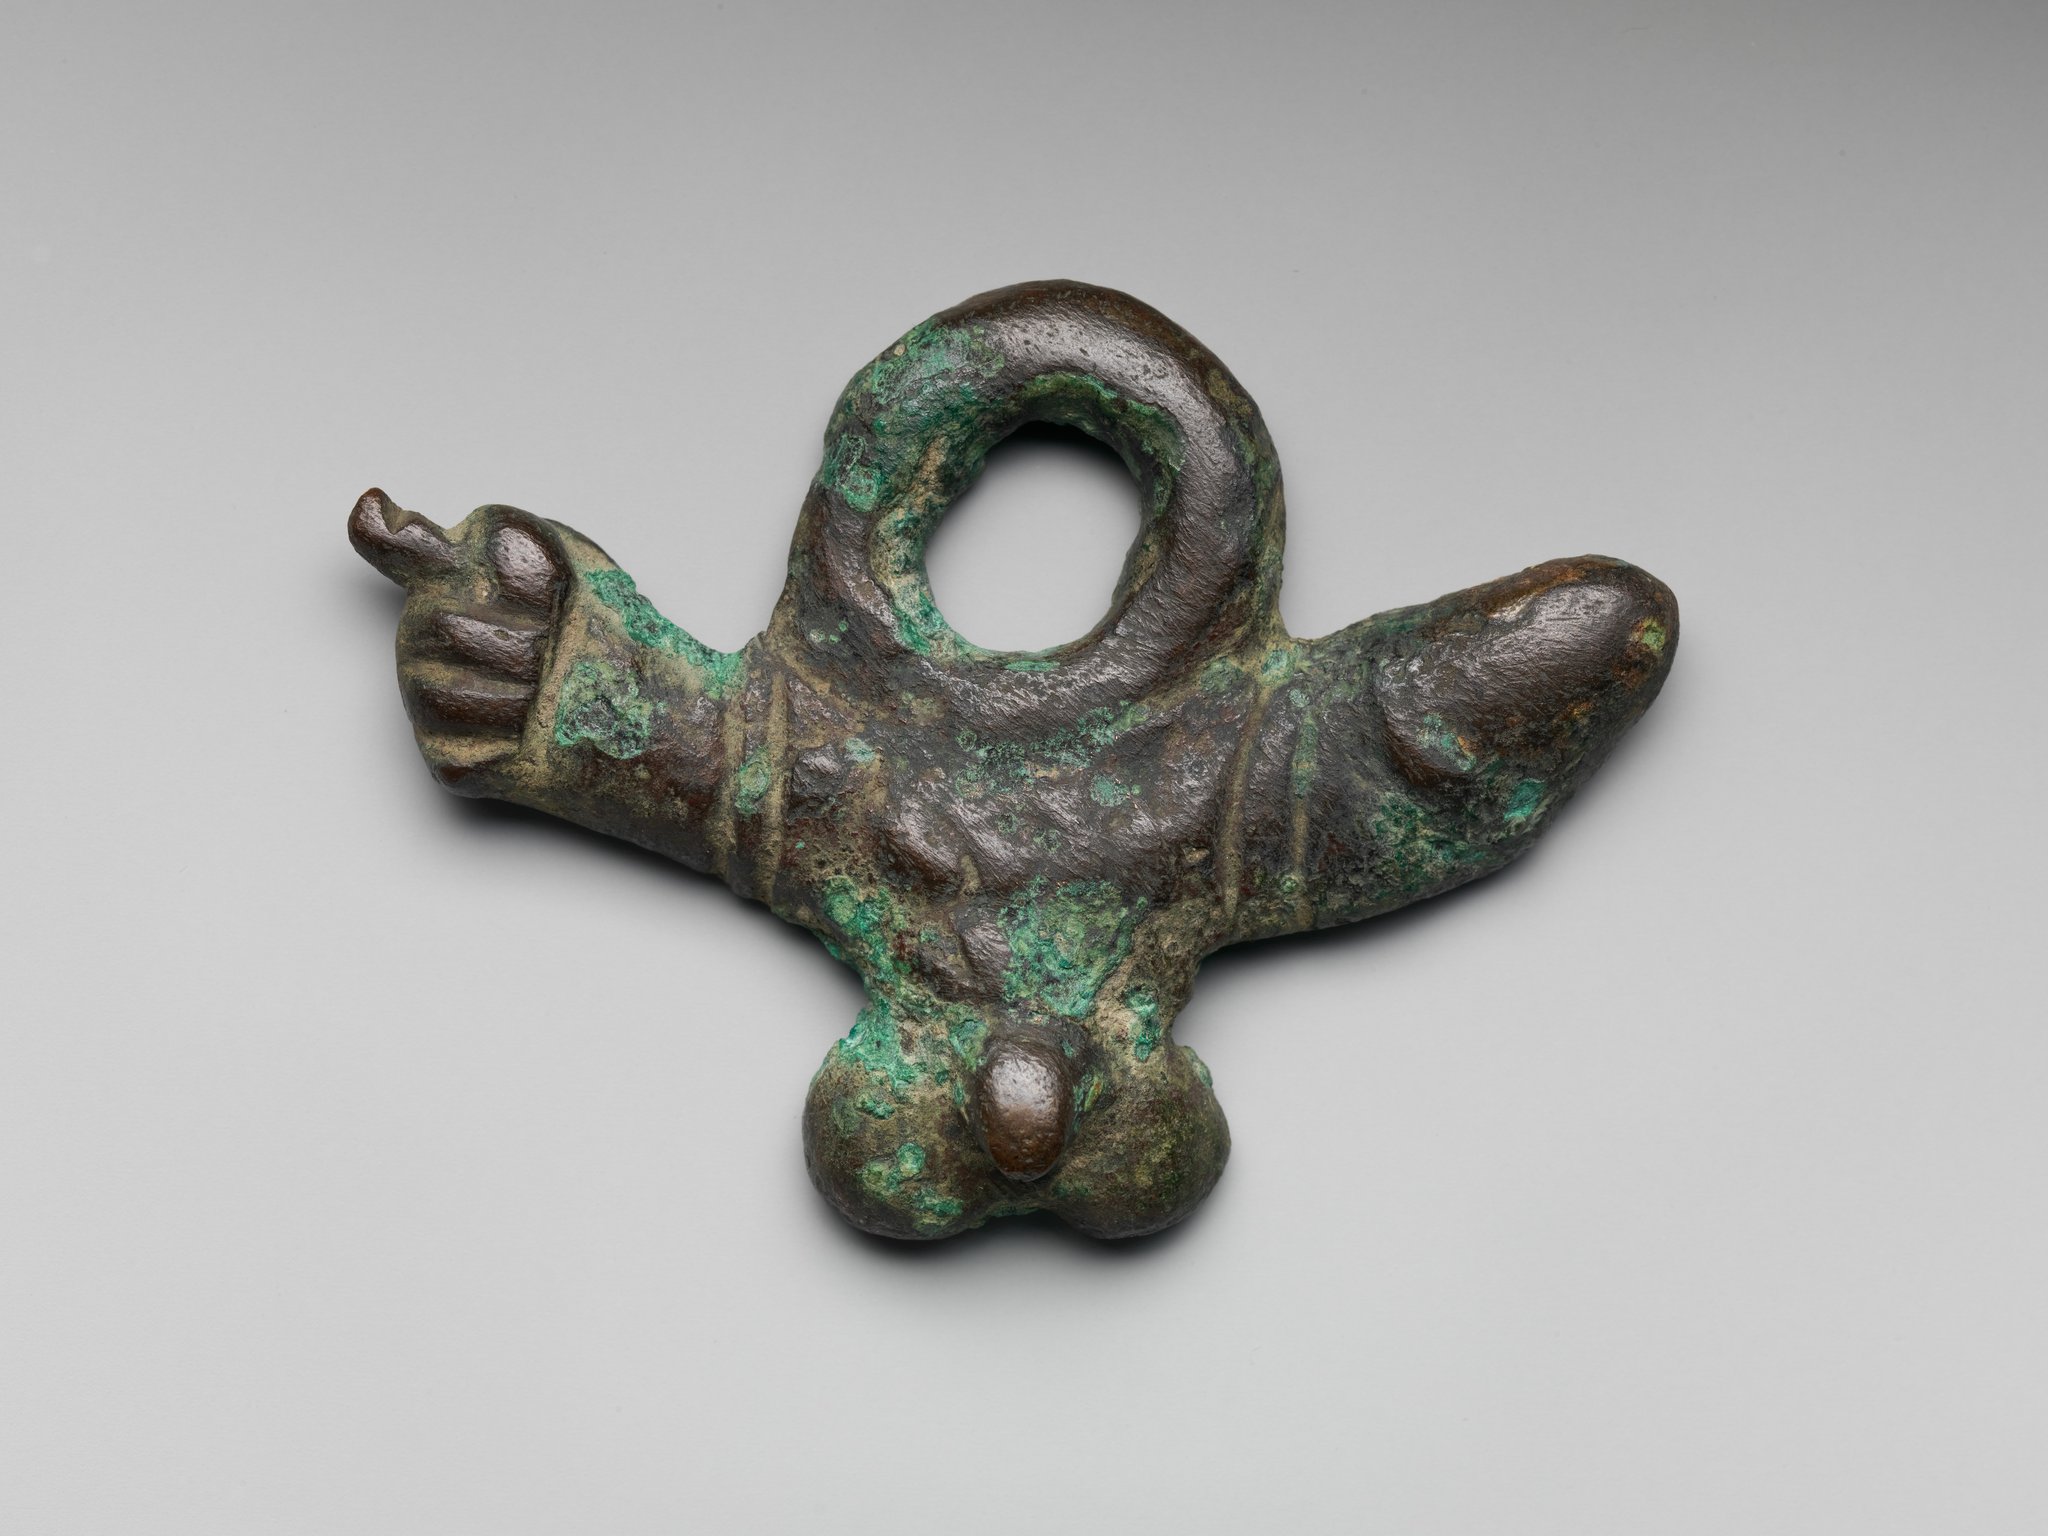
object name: amulet, grotesque ornament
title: Bronze phallic amulet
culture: roman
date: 1-100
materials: bronze